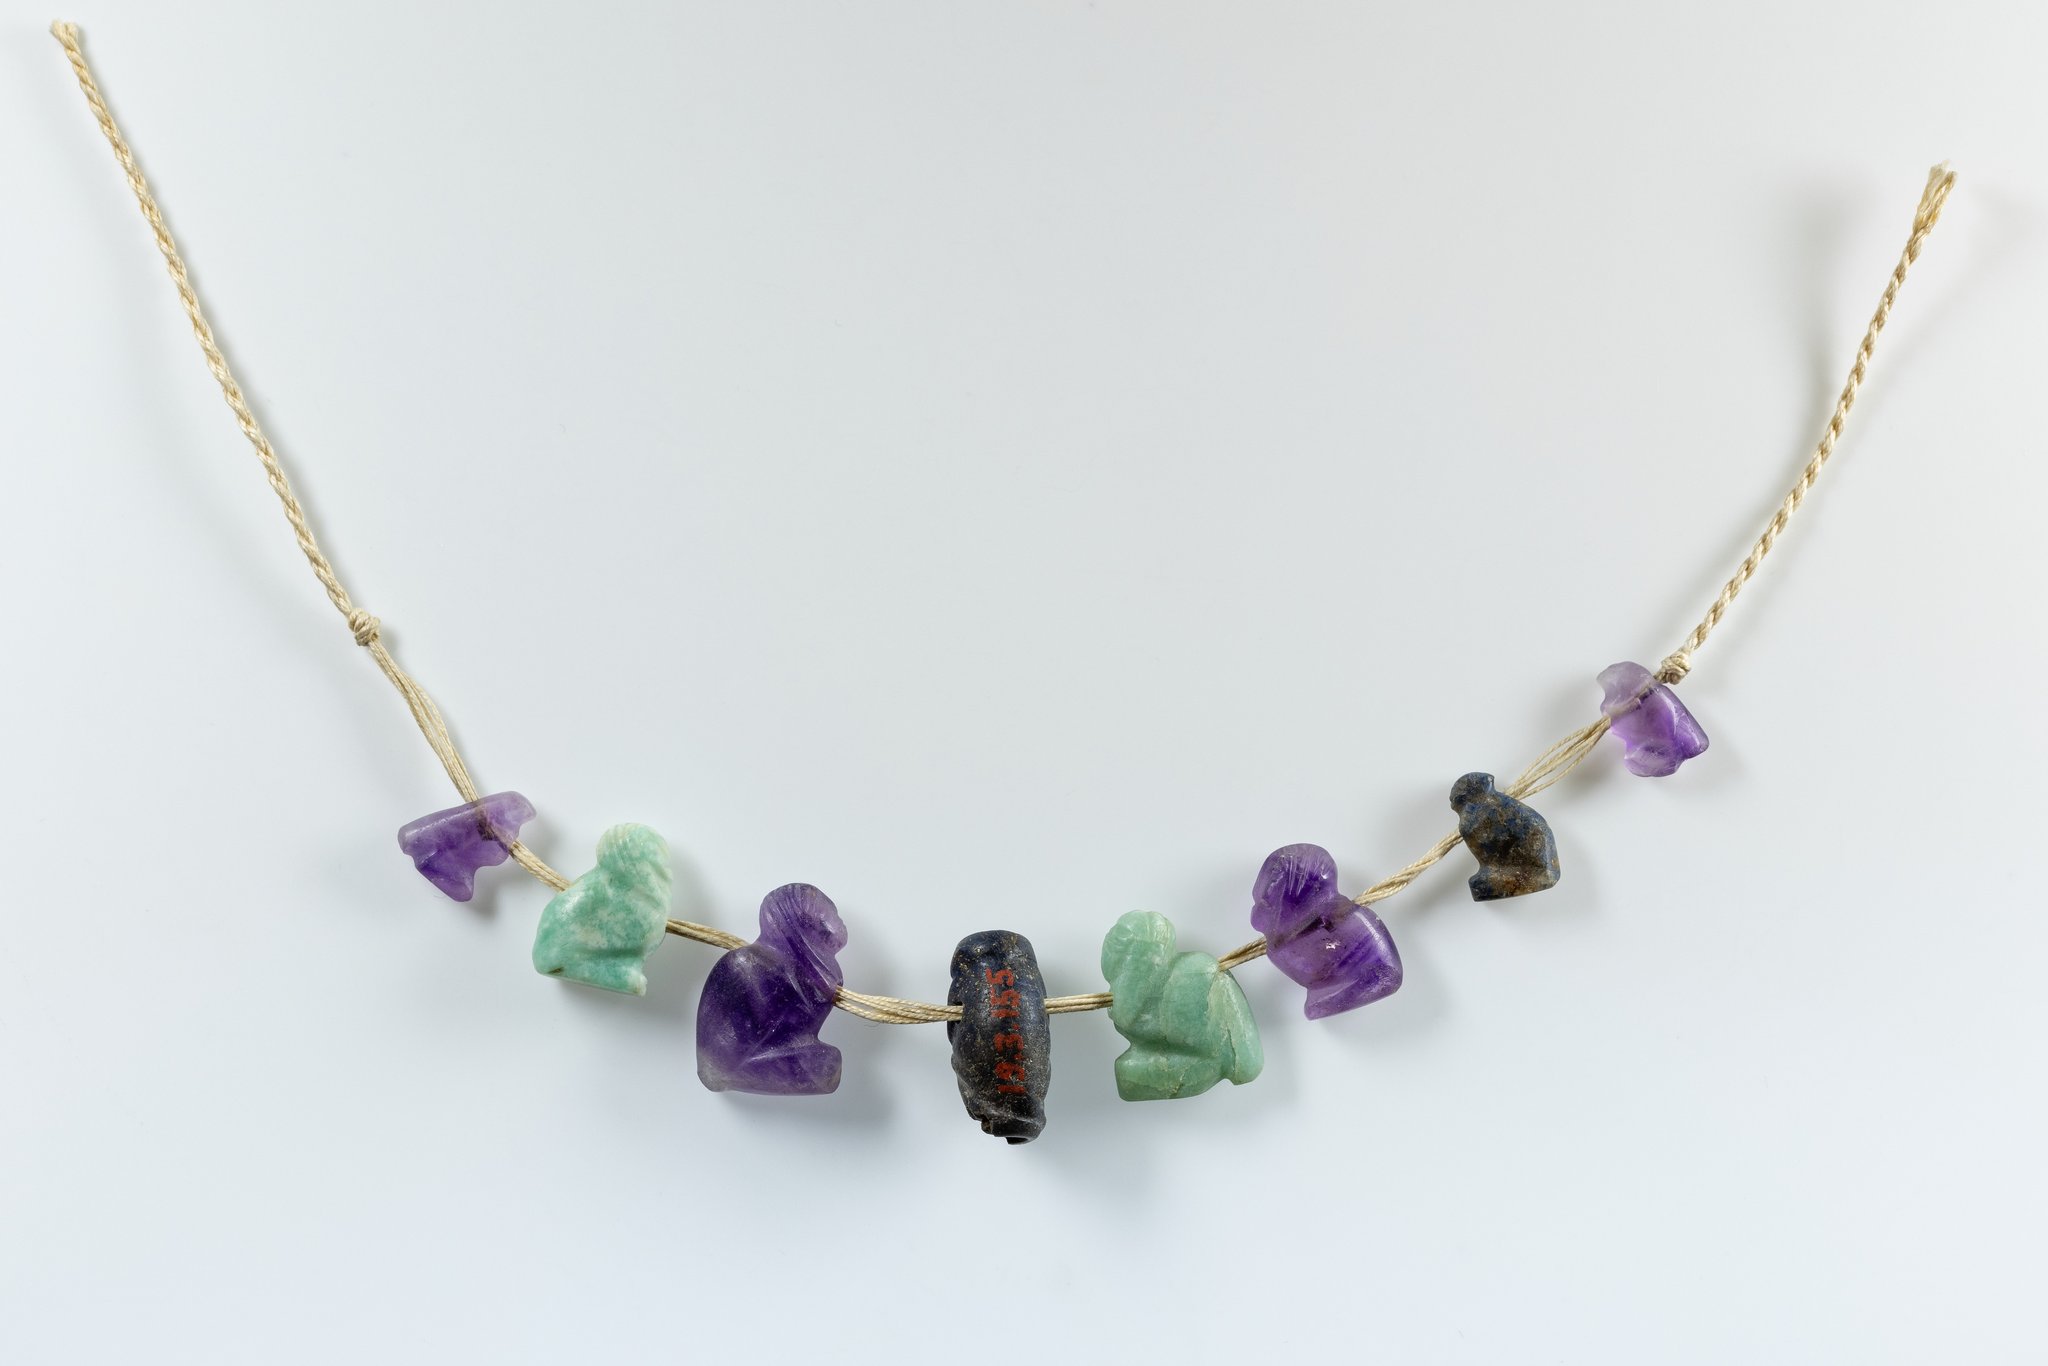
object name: string of 1 squatting ape, 5 ba bird, and 2 horus amulet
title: String of 1 squatting ape, 5 Ba birds, and 2 Horus amulets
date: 2030-1640 BCE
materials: gemstone, lapis lazuli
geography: egypt